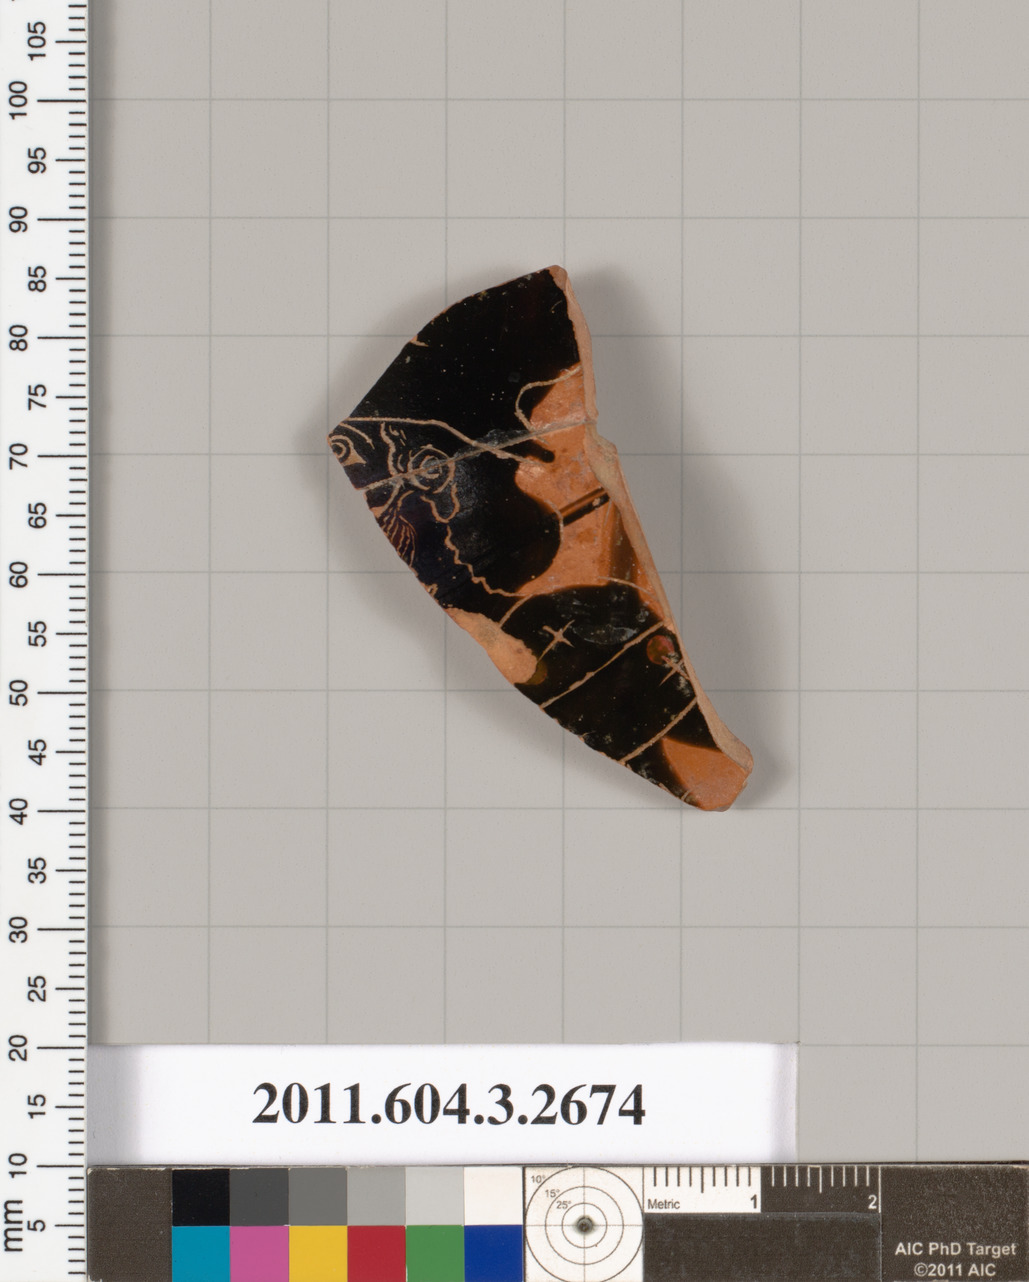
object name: oinochoe fragment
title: Terracotta fragment of an oinochoe (jug)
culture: greek, attic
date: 540-530 BCE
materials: terracotta